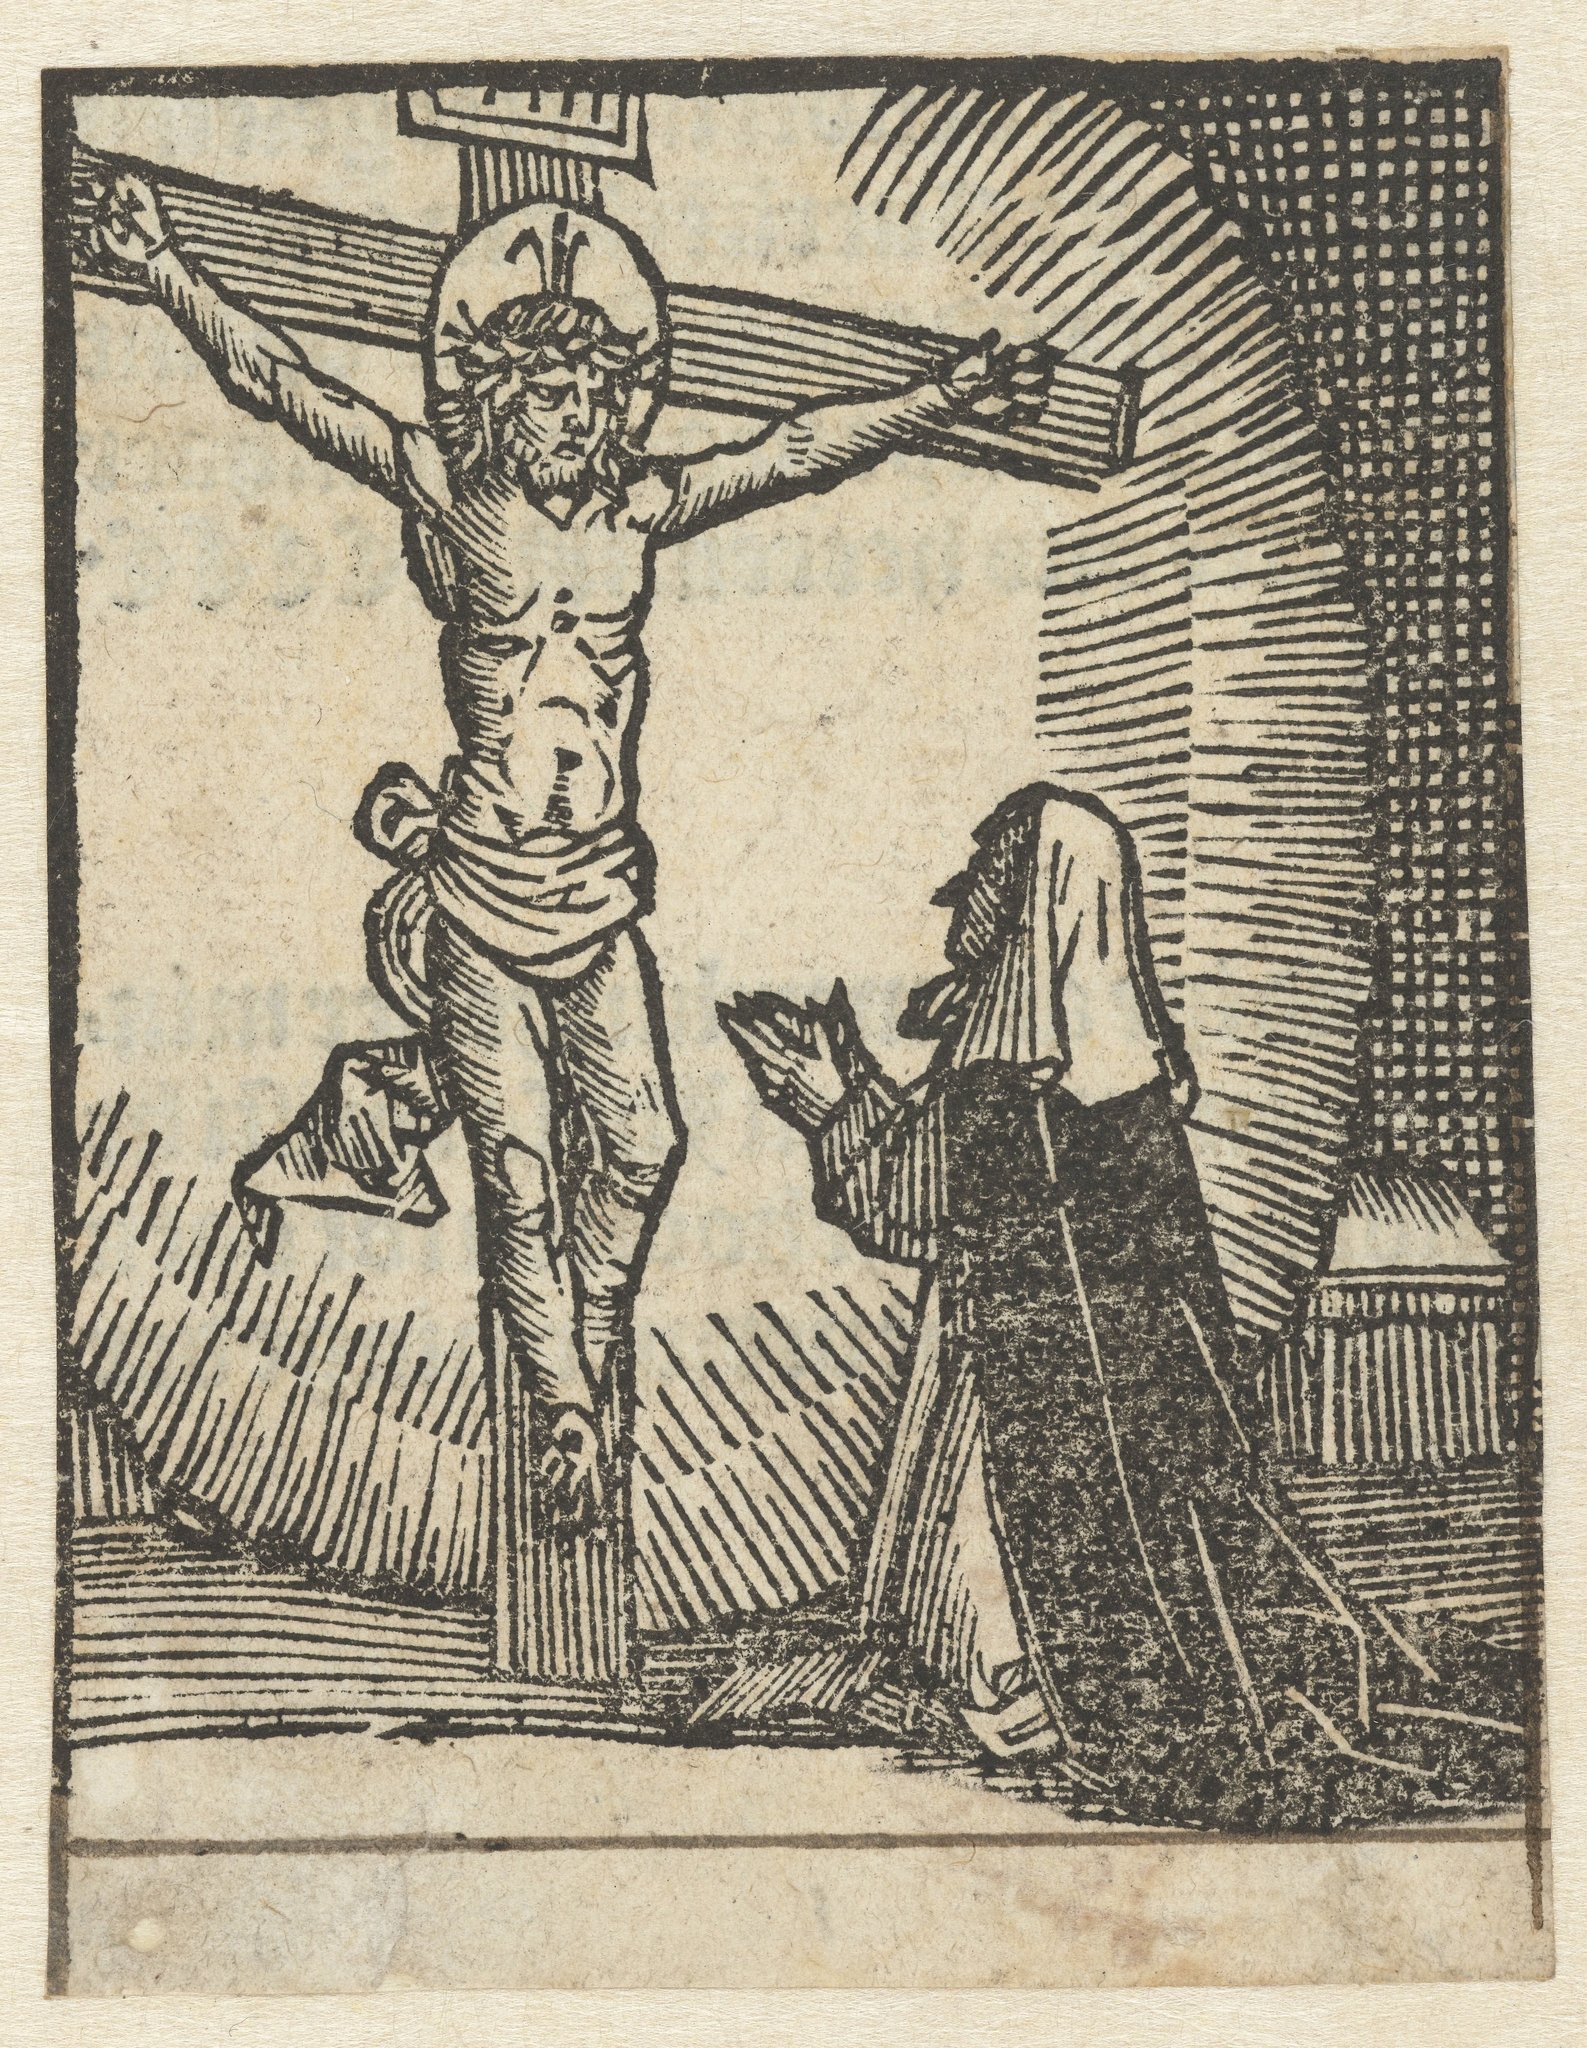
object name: book illustration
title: Verschijning van Christus voor non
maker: Anonymous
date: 1490-1500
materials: paper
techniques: woodcut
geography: low countries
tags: nun(s), specific types of crucified christ (in non-narrative context) (+ donor(s), supplicant(s), whether or not with patron saint(s))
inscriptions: collector's mark: Lugt 240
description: Blad uit een boek. Christus aan het kruis verschijnt aan een knielende non.